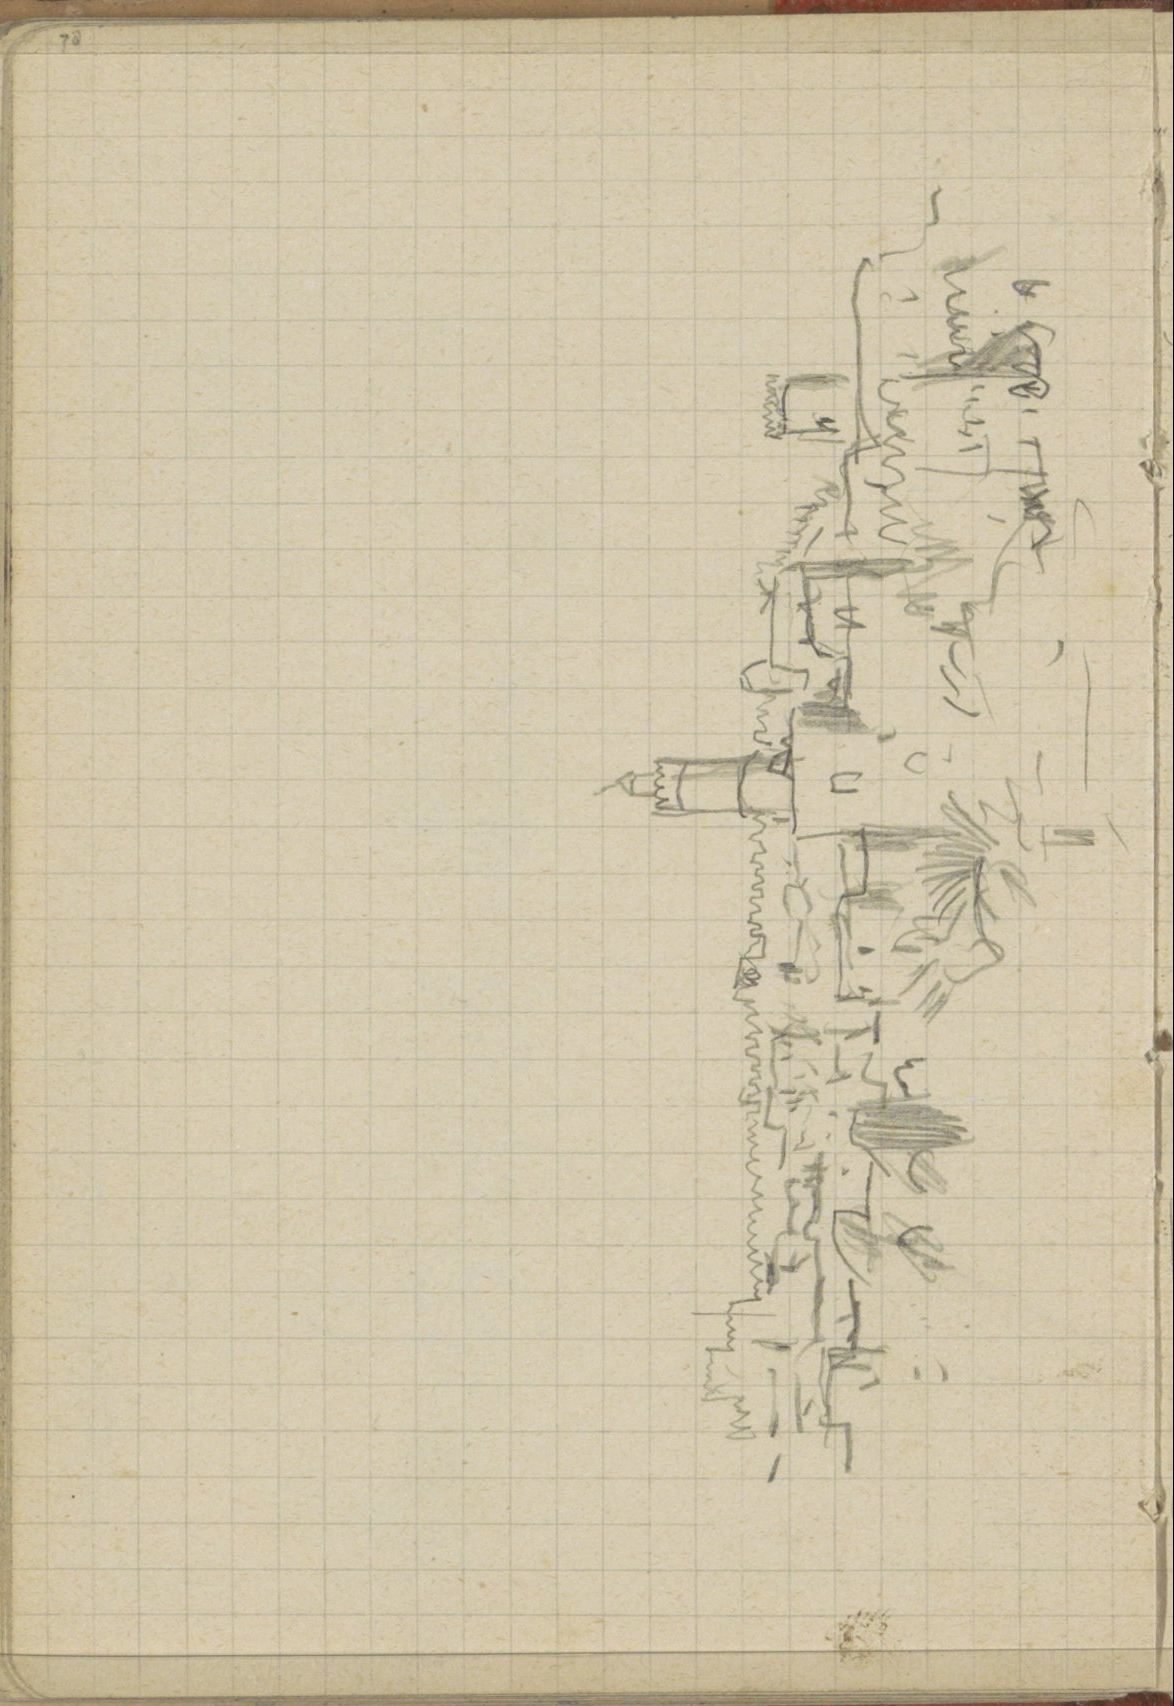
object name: sketchbook leaf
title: Gezicht op een stad met een verdedigingsmuur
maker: marius bauer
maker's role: draughtsman, print maker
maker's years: 1867-1932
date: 1909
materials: pencil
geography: tunisia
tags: city-view, and landscape with man-made constructions, towers ~ fortified city, walls ~ fortified city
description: Pagina 78 uit een schetsboek met 67 bladen.